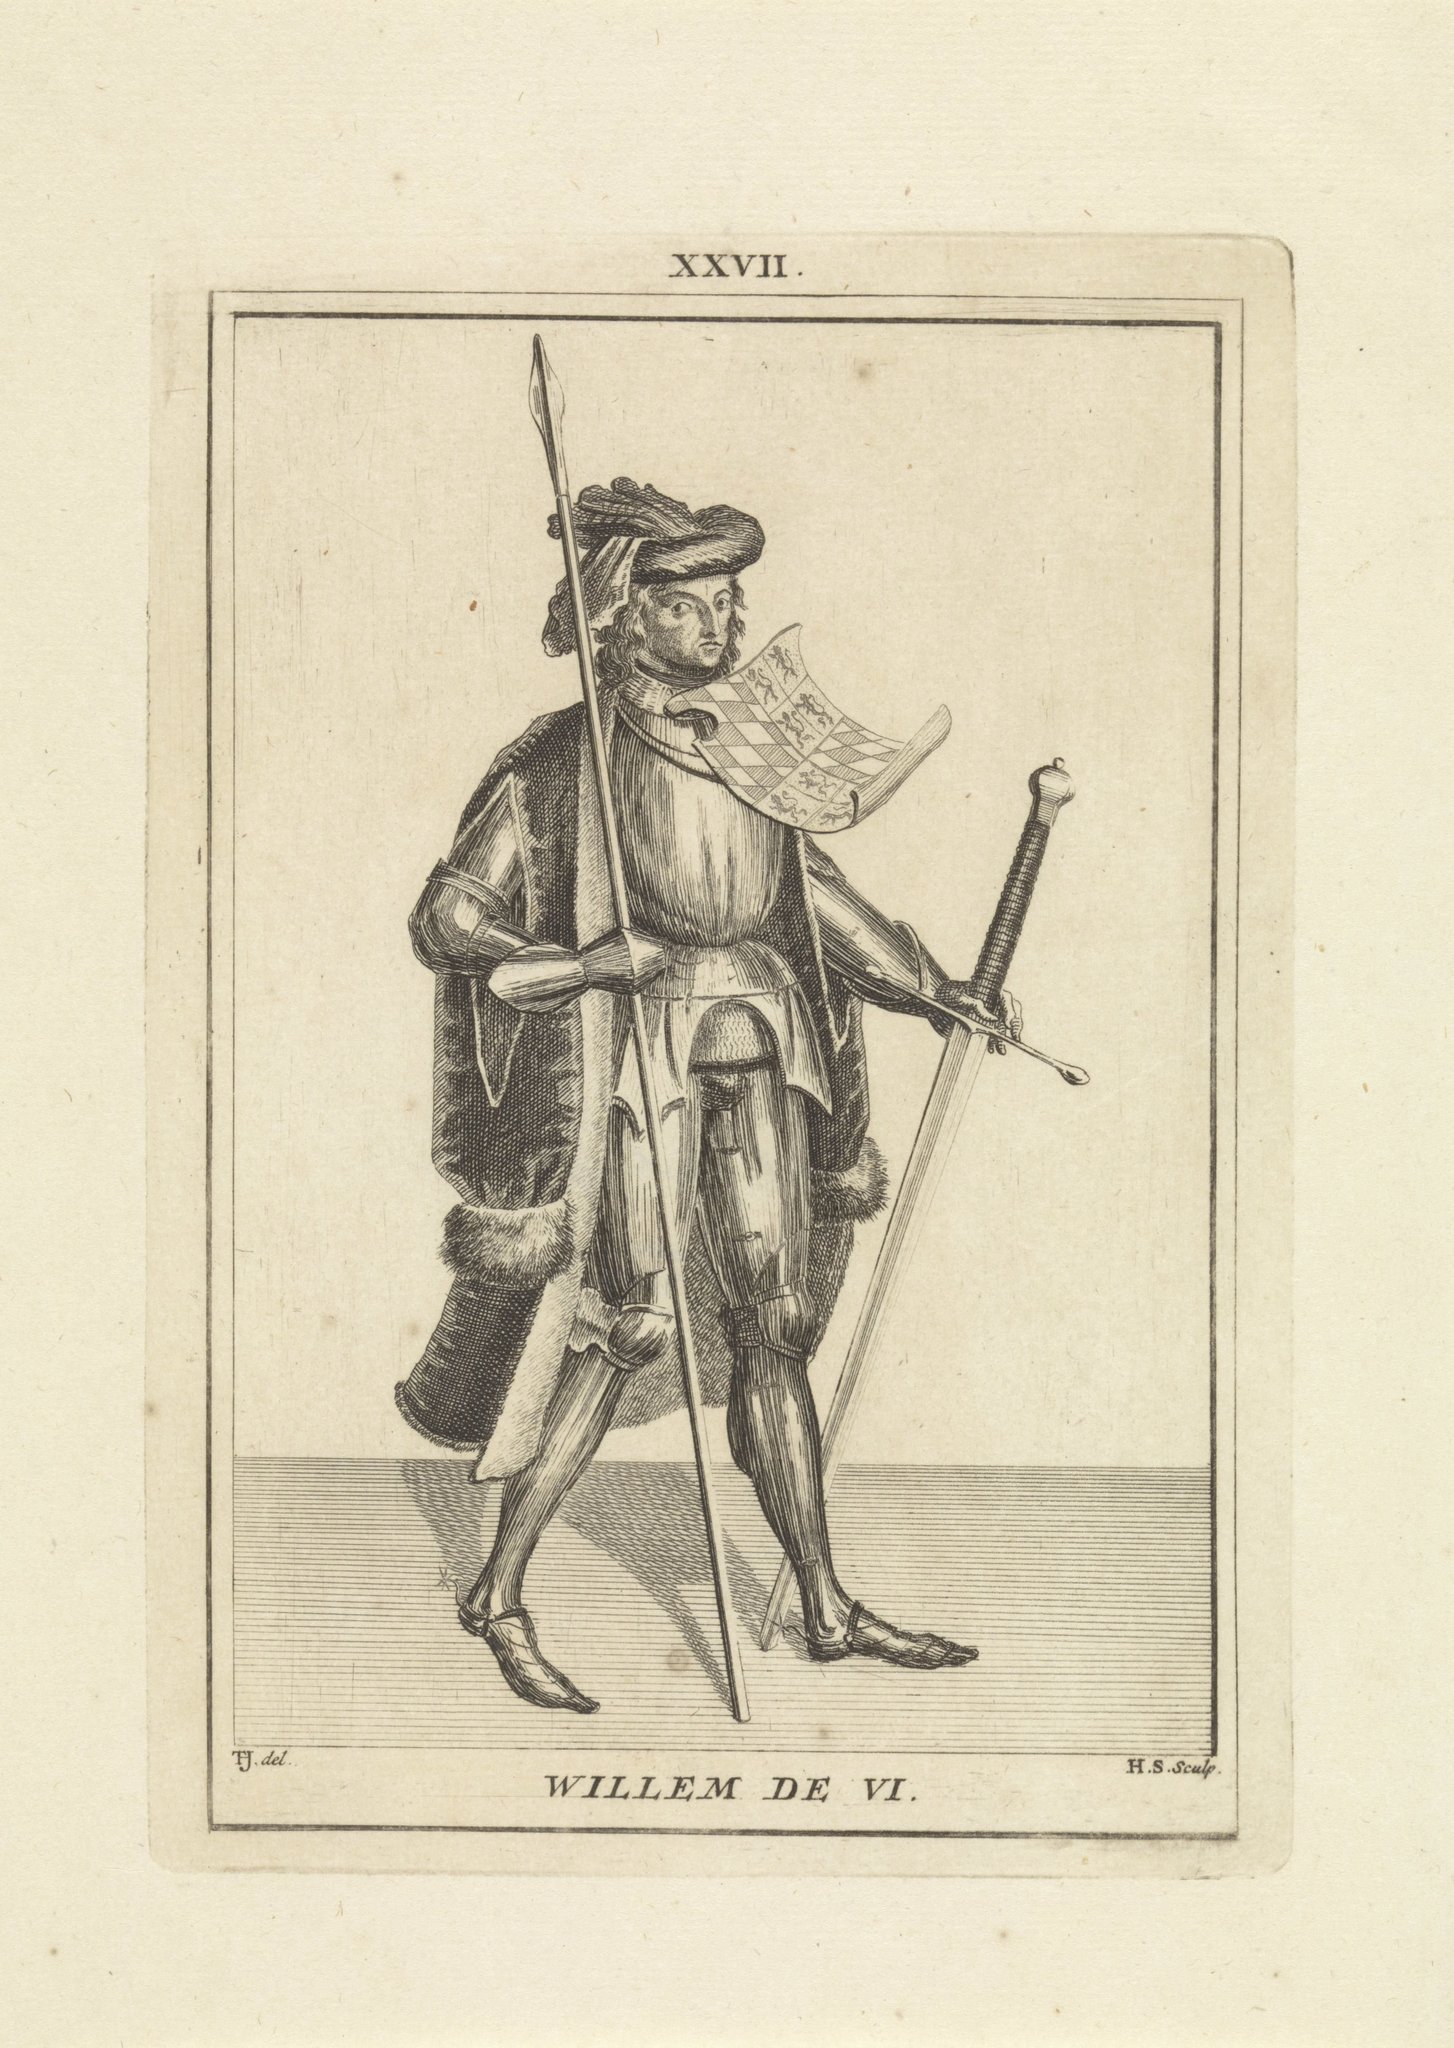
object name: print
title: Portret van Willem VI van Henegouwen, Holland en Zeeland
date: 1745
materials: paper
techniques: etching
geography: haarlem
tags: holland en zeeland willem vi van henegouwen, nobility and patriciate; chivalry, knighthood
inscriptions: collector's mark: Lugt 2228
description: Boekillustratie voor: Langendyk, Pieter. De Graaven van Holland, in jaardichten beschreven door Pieter Langendyk. Verykt met alle de beeldtenissen dier prinsen, naauwkeurig getekend naar de echte aloude tafereelen of de zaal van't raadhuis der stad Haarlem. Haarlem: J. Bosch, 1745.